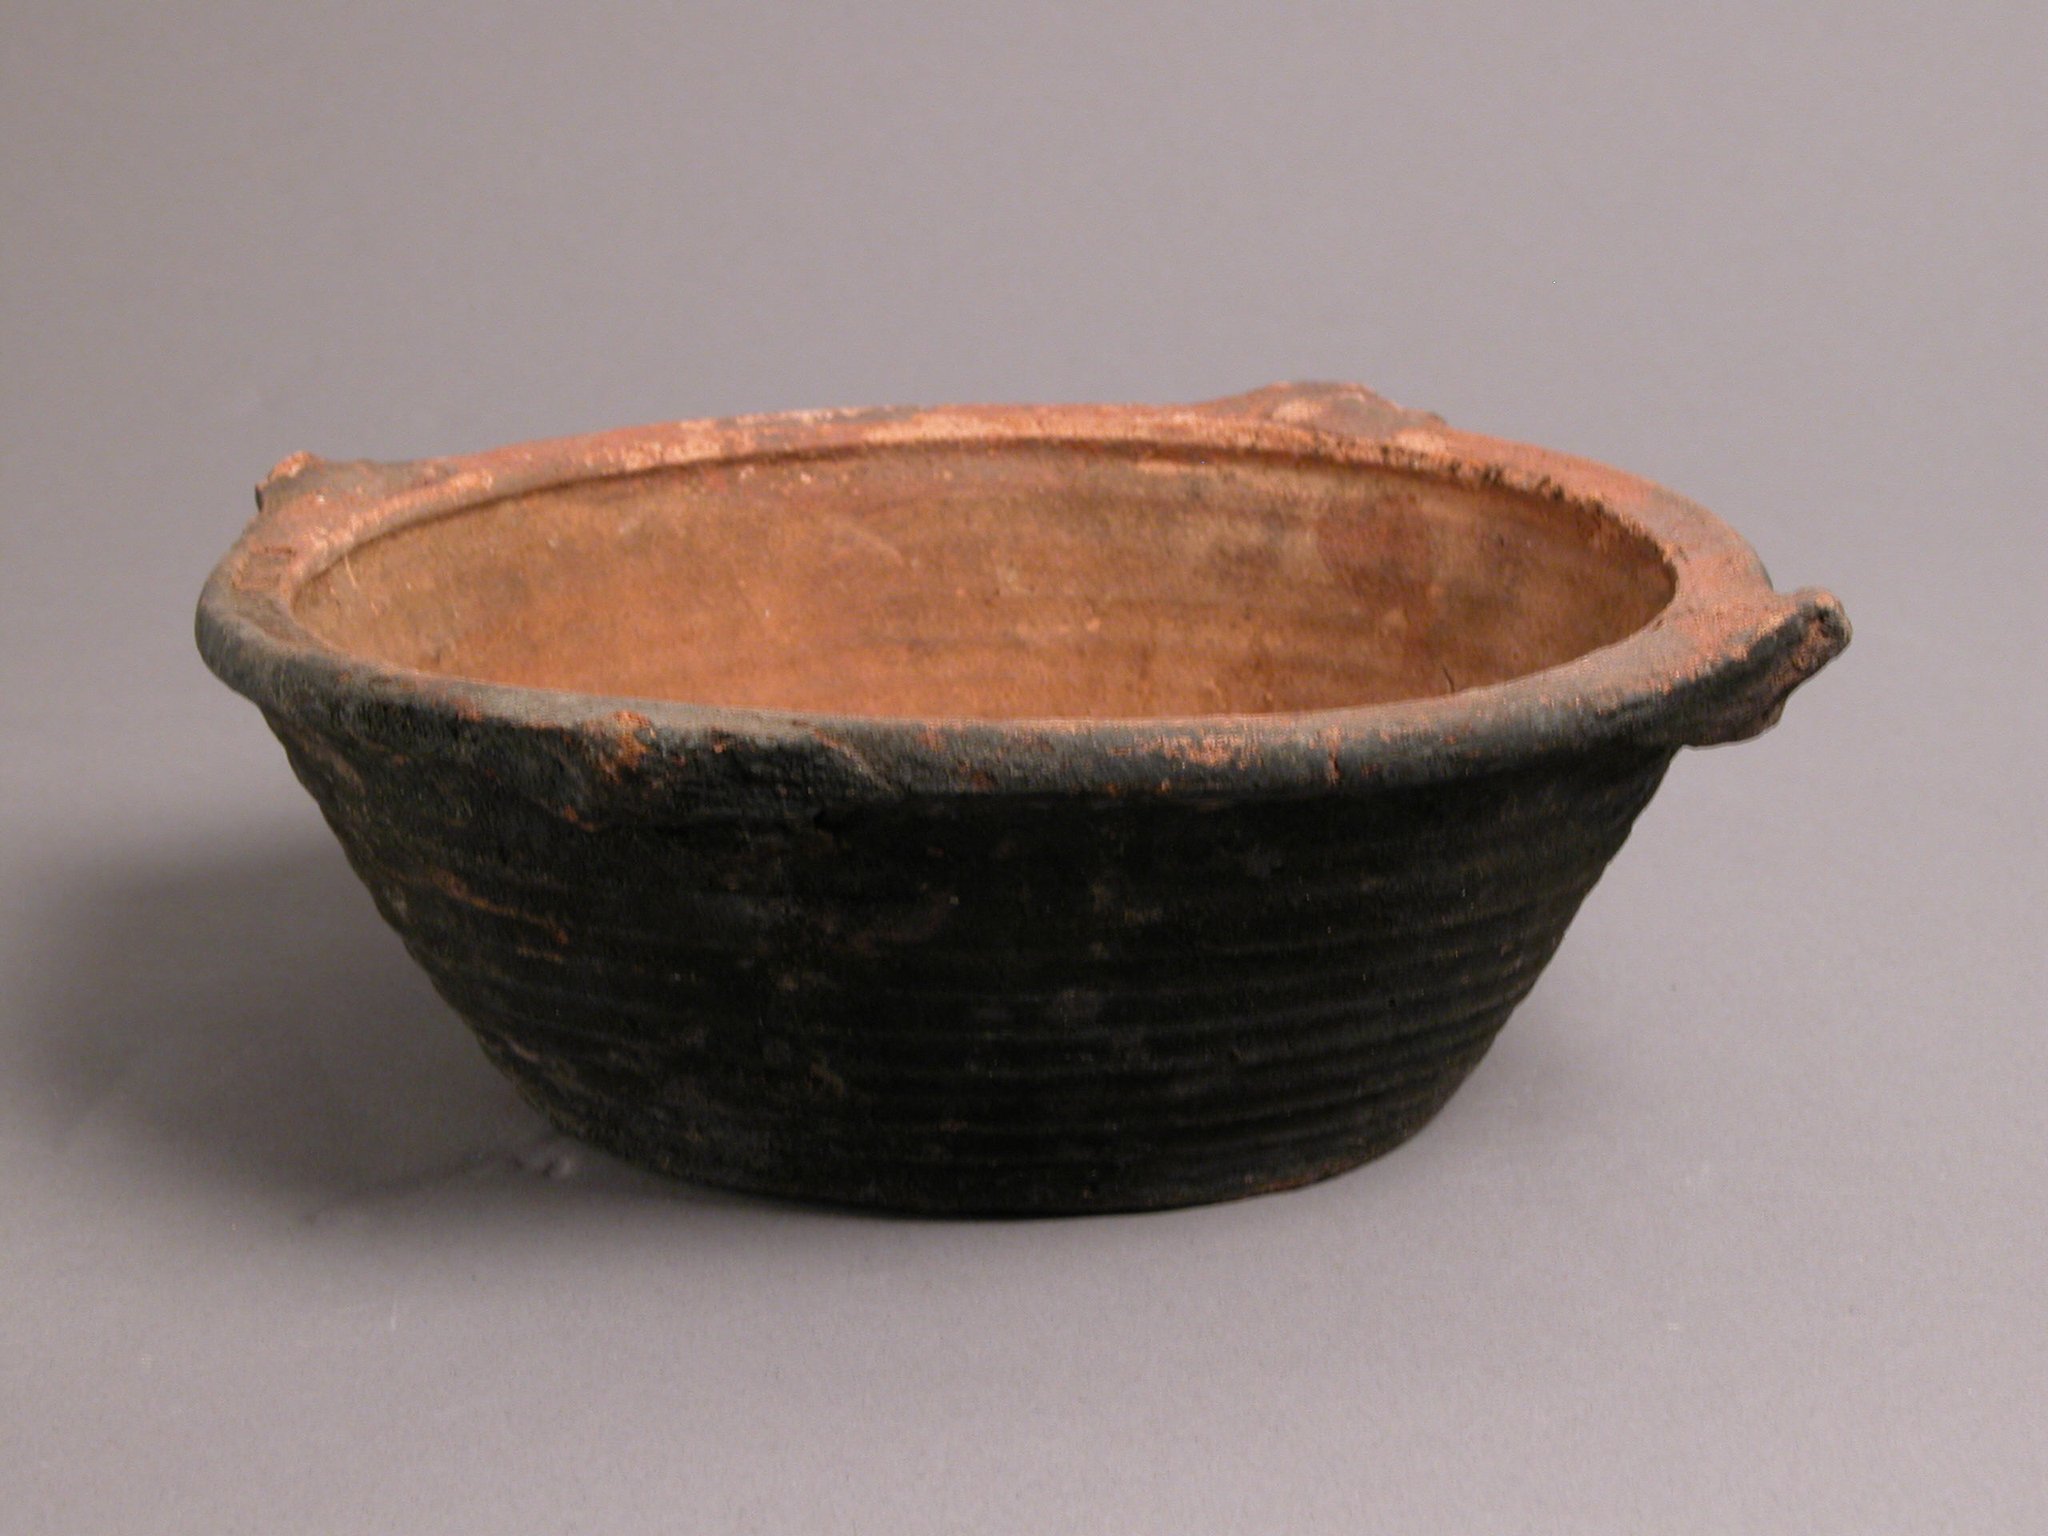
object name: bowl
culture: coptic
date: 301-700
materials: earthenware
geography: egypt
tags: bowls